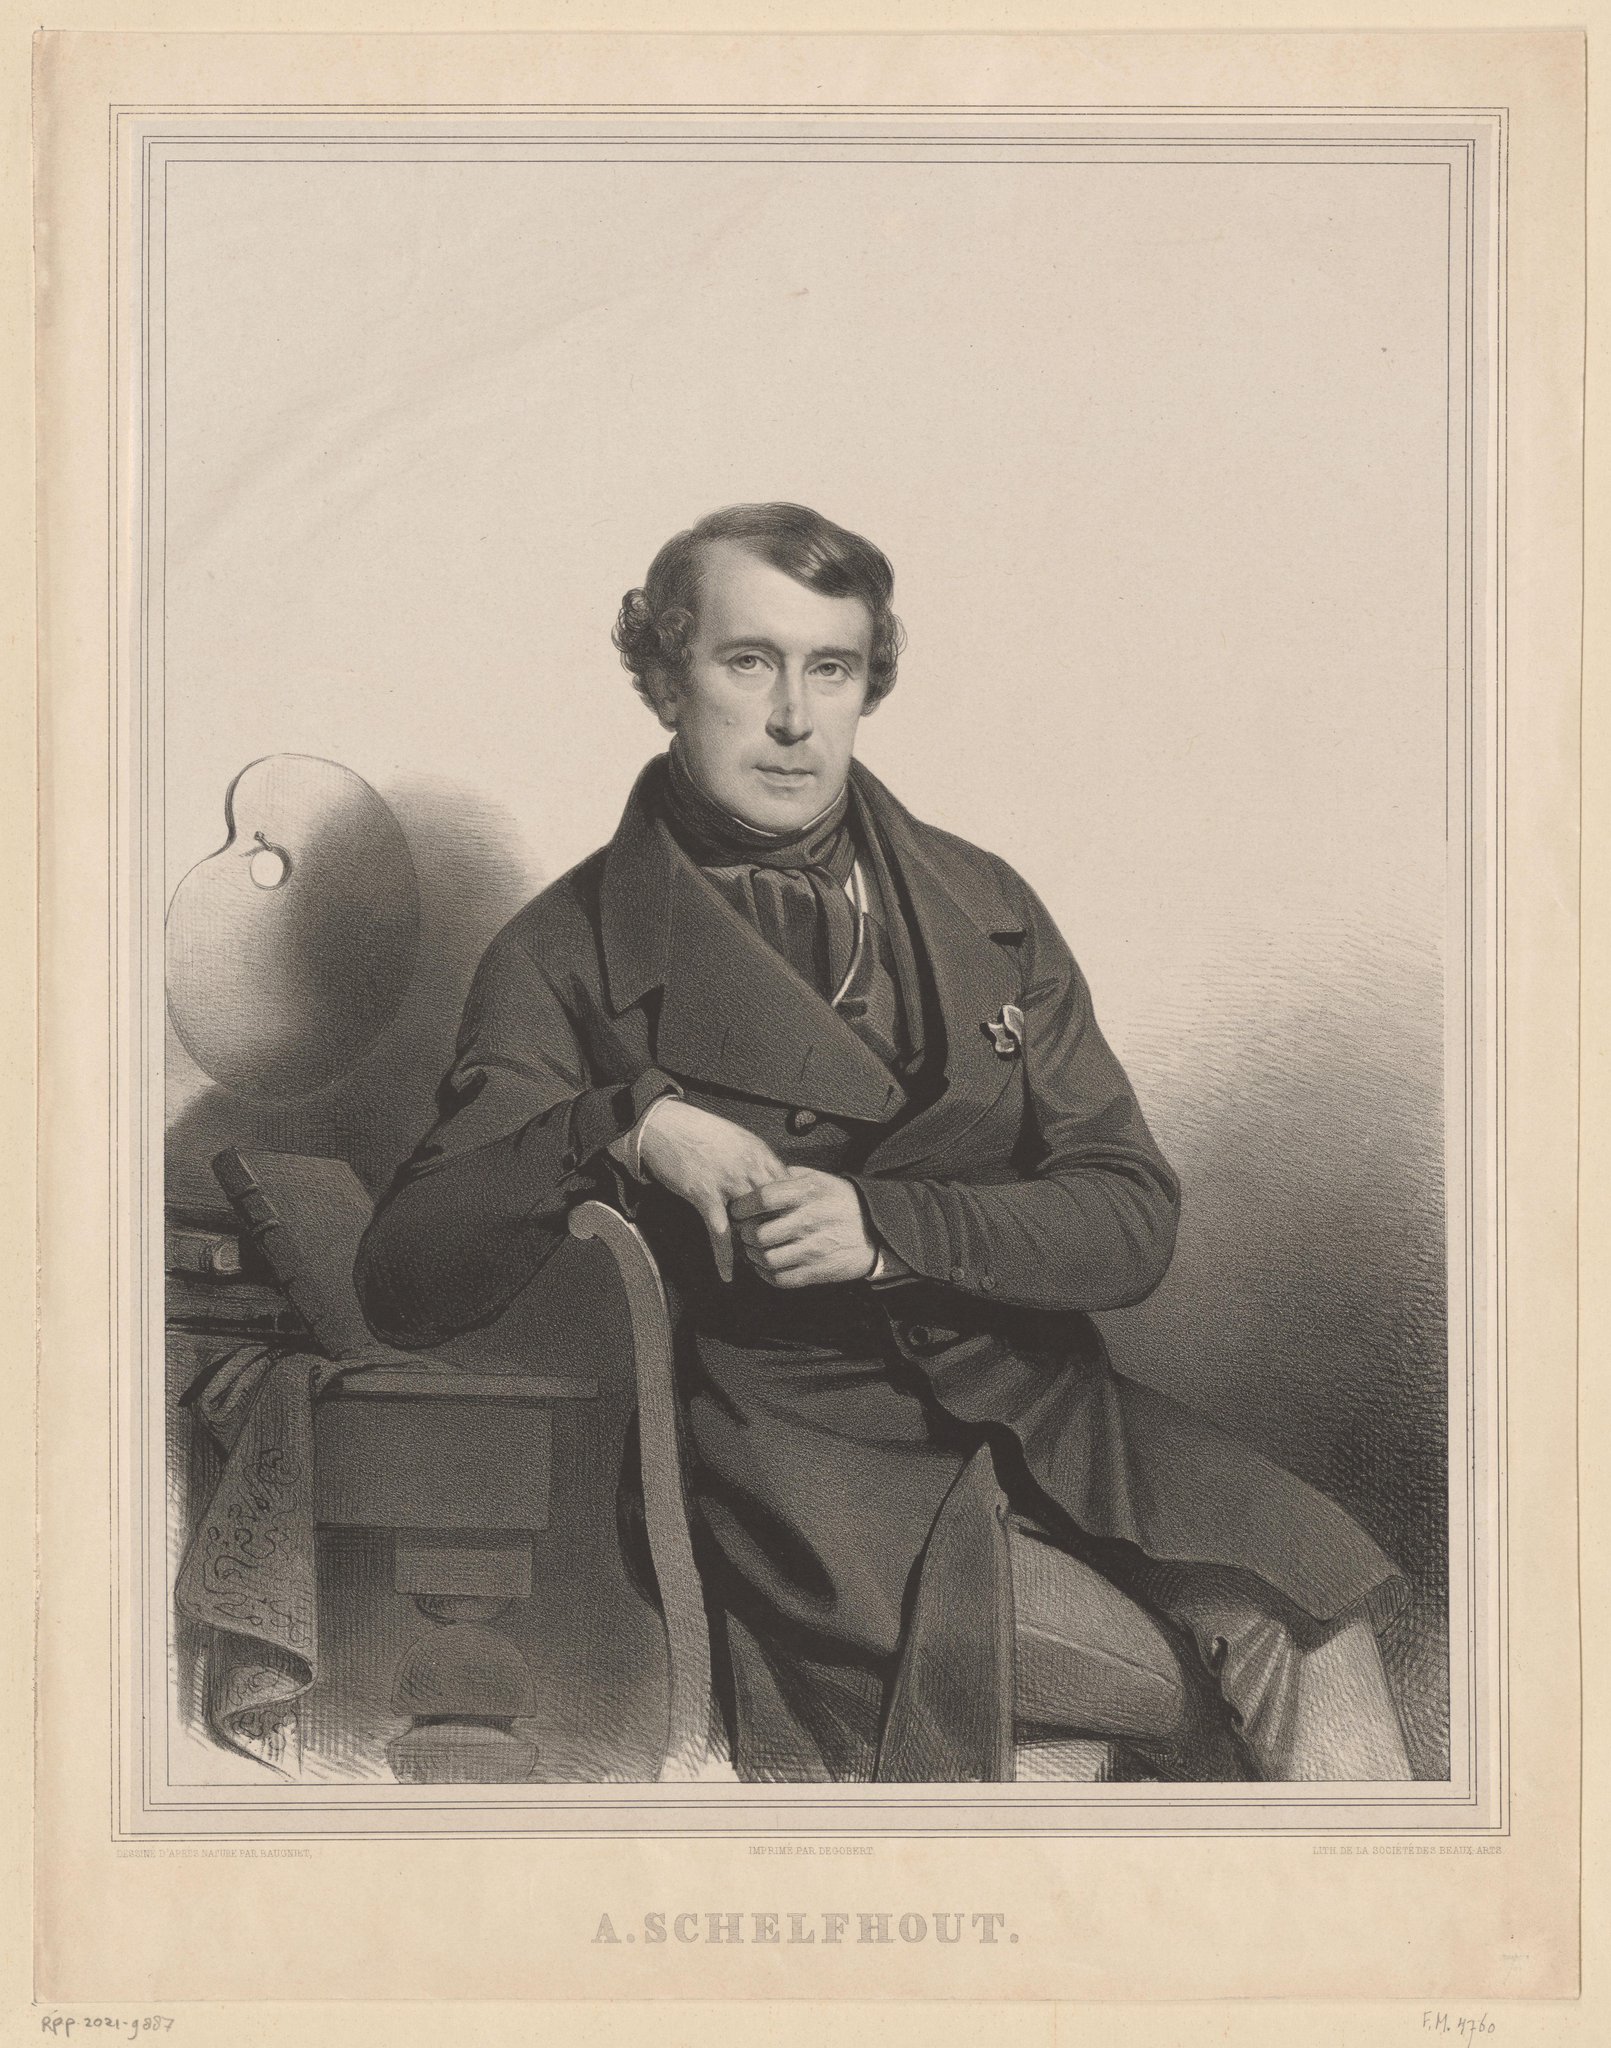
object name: print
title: Portret van Andreas Schelfhout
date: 1839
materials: paper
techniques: lithograph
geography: brussels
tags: print maker, draughtsman, andreas schelfhout, adult man, historical persons, palette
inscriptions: collector's mark: Lugt 2228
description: Prent waarschijnlijk uit: Baugniet, Charles. Les artistes contemporains: portraits lithographiés d'après nature, accompagnés de notices sur la vie et les ouvrages de chacun d'eux. Brussel: De Wasme-Pletinckx, 1839.